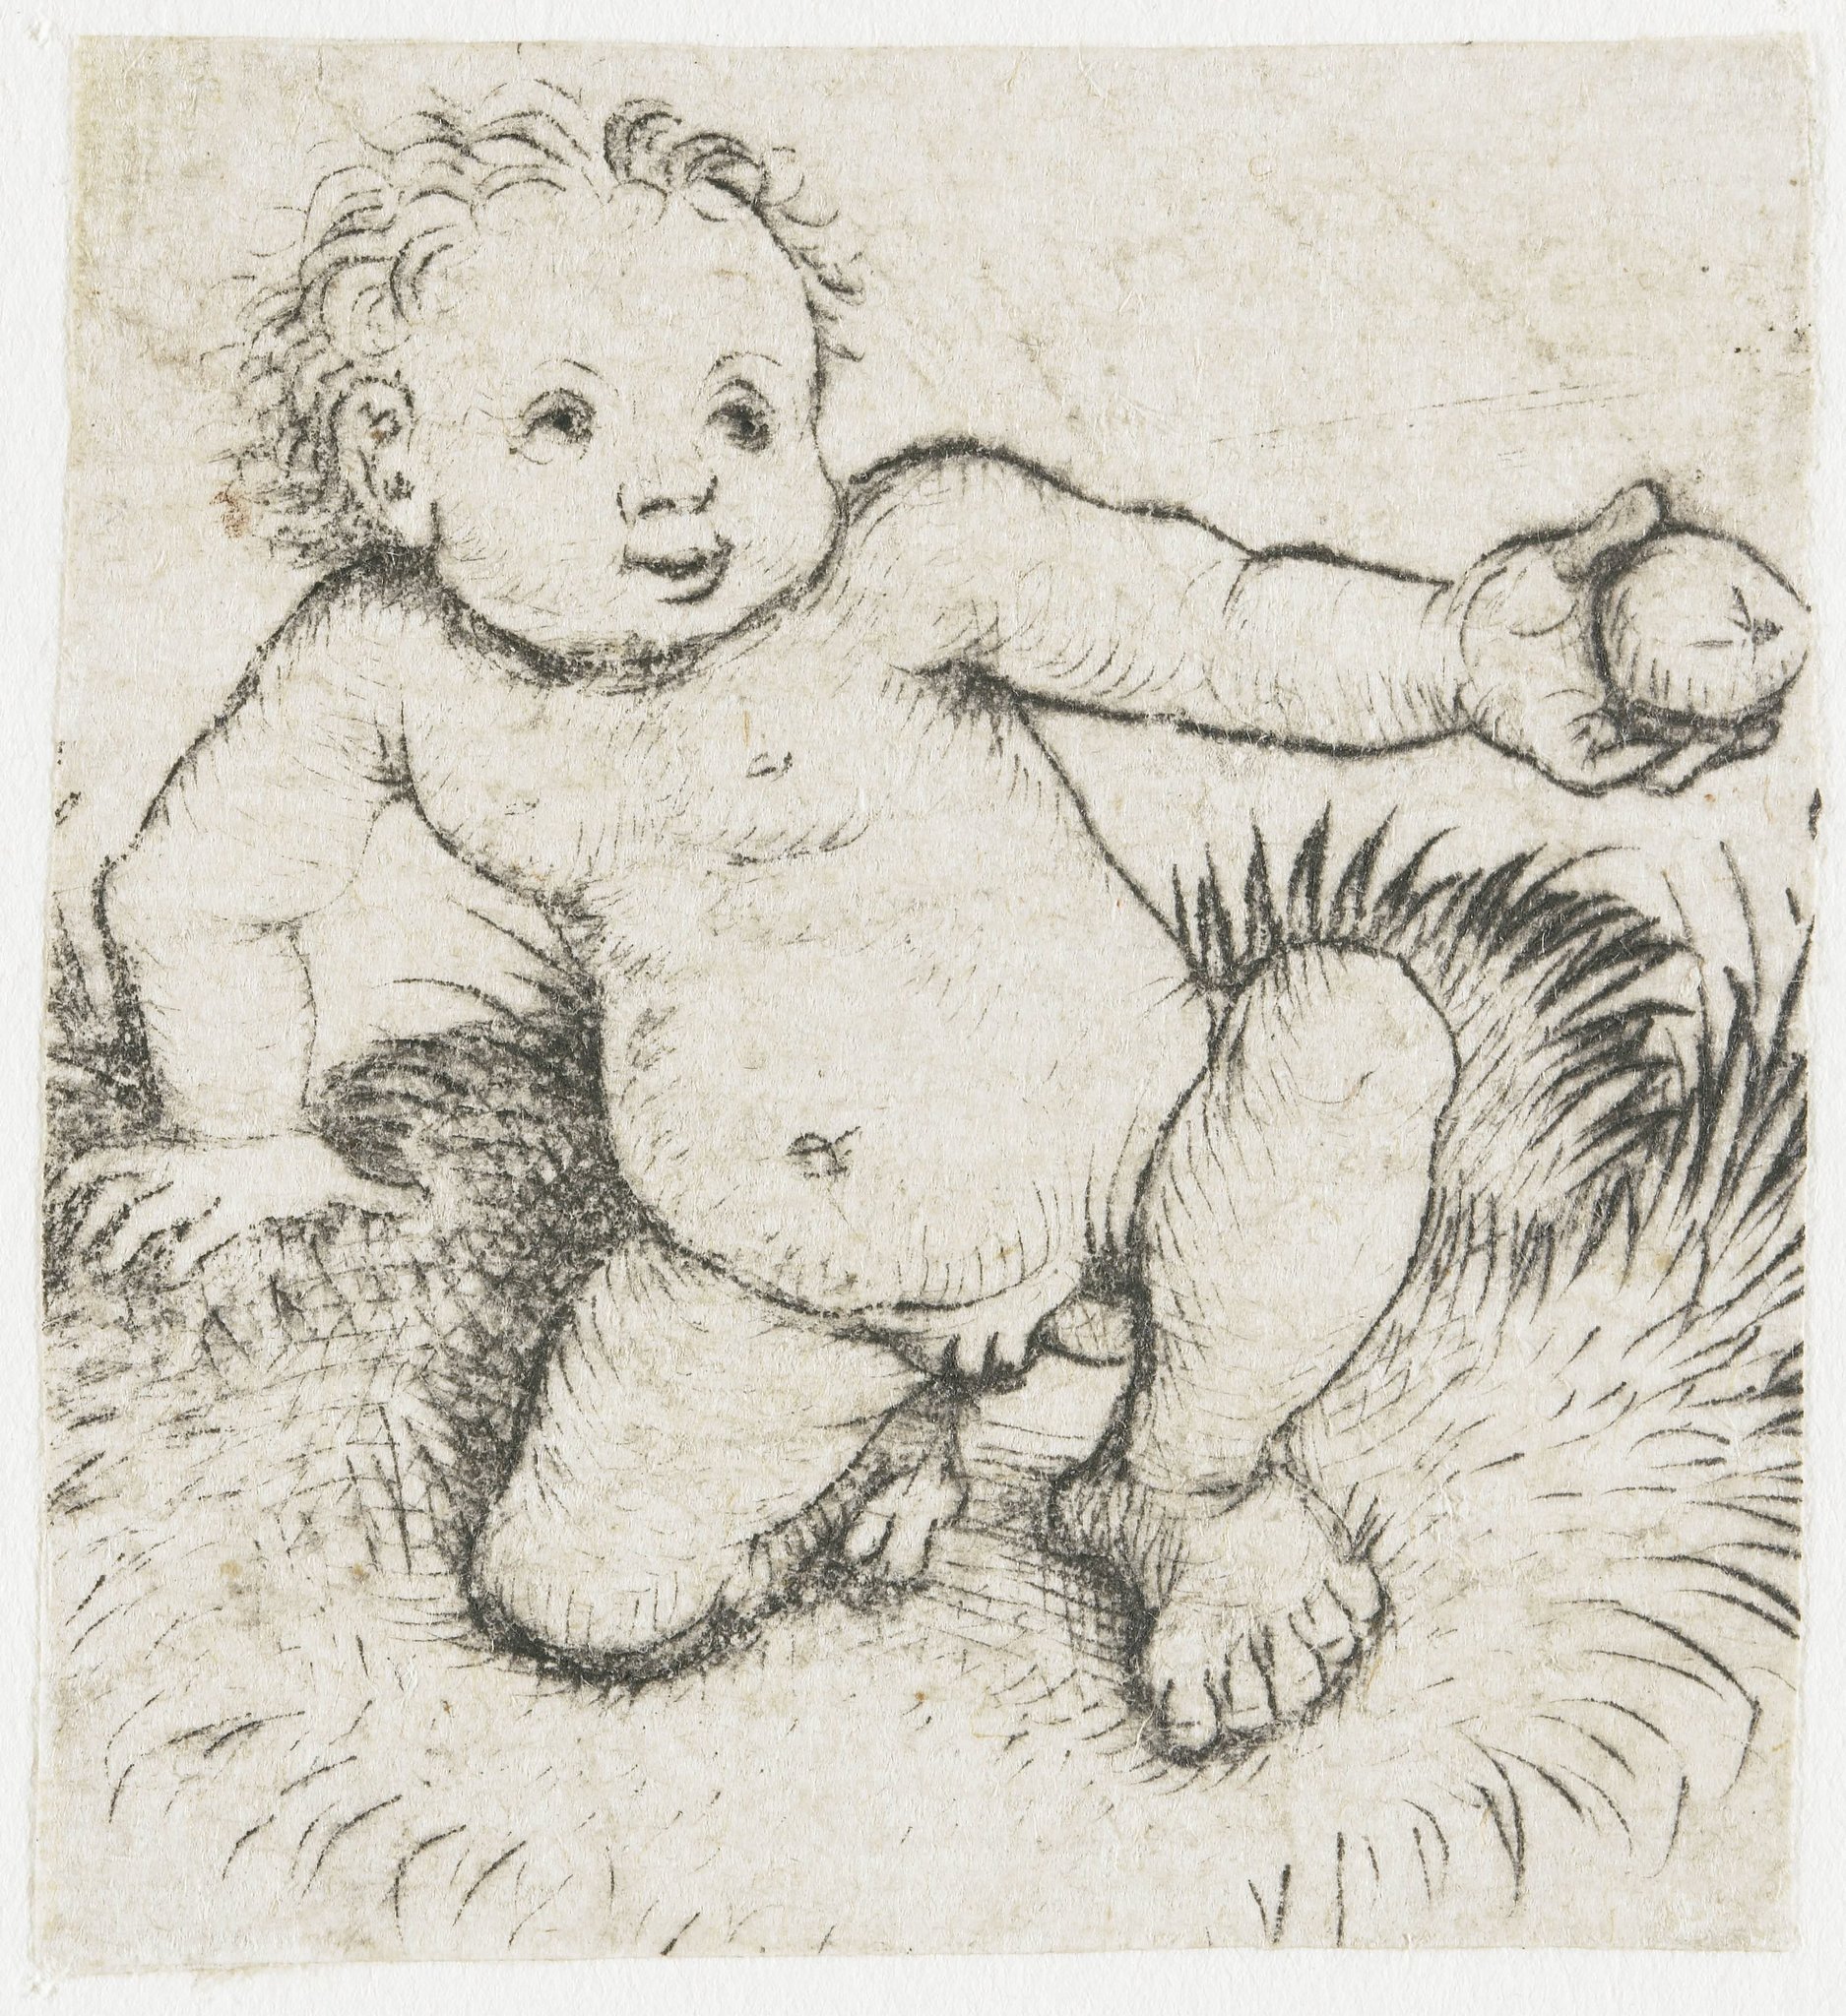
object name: print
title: Zittend kind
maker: meester van het amsterdamse kabinet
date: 1470-1475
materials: paper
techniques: drypoint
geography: germany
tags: toddler (male)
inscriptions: collector's mark: Lugt 2228a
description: Spelende peuter met een vrucht in linkerhand.